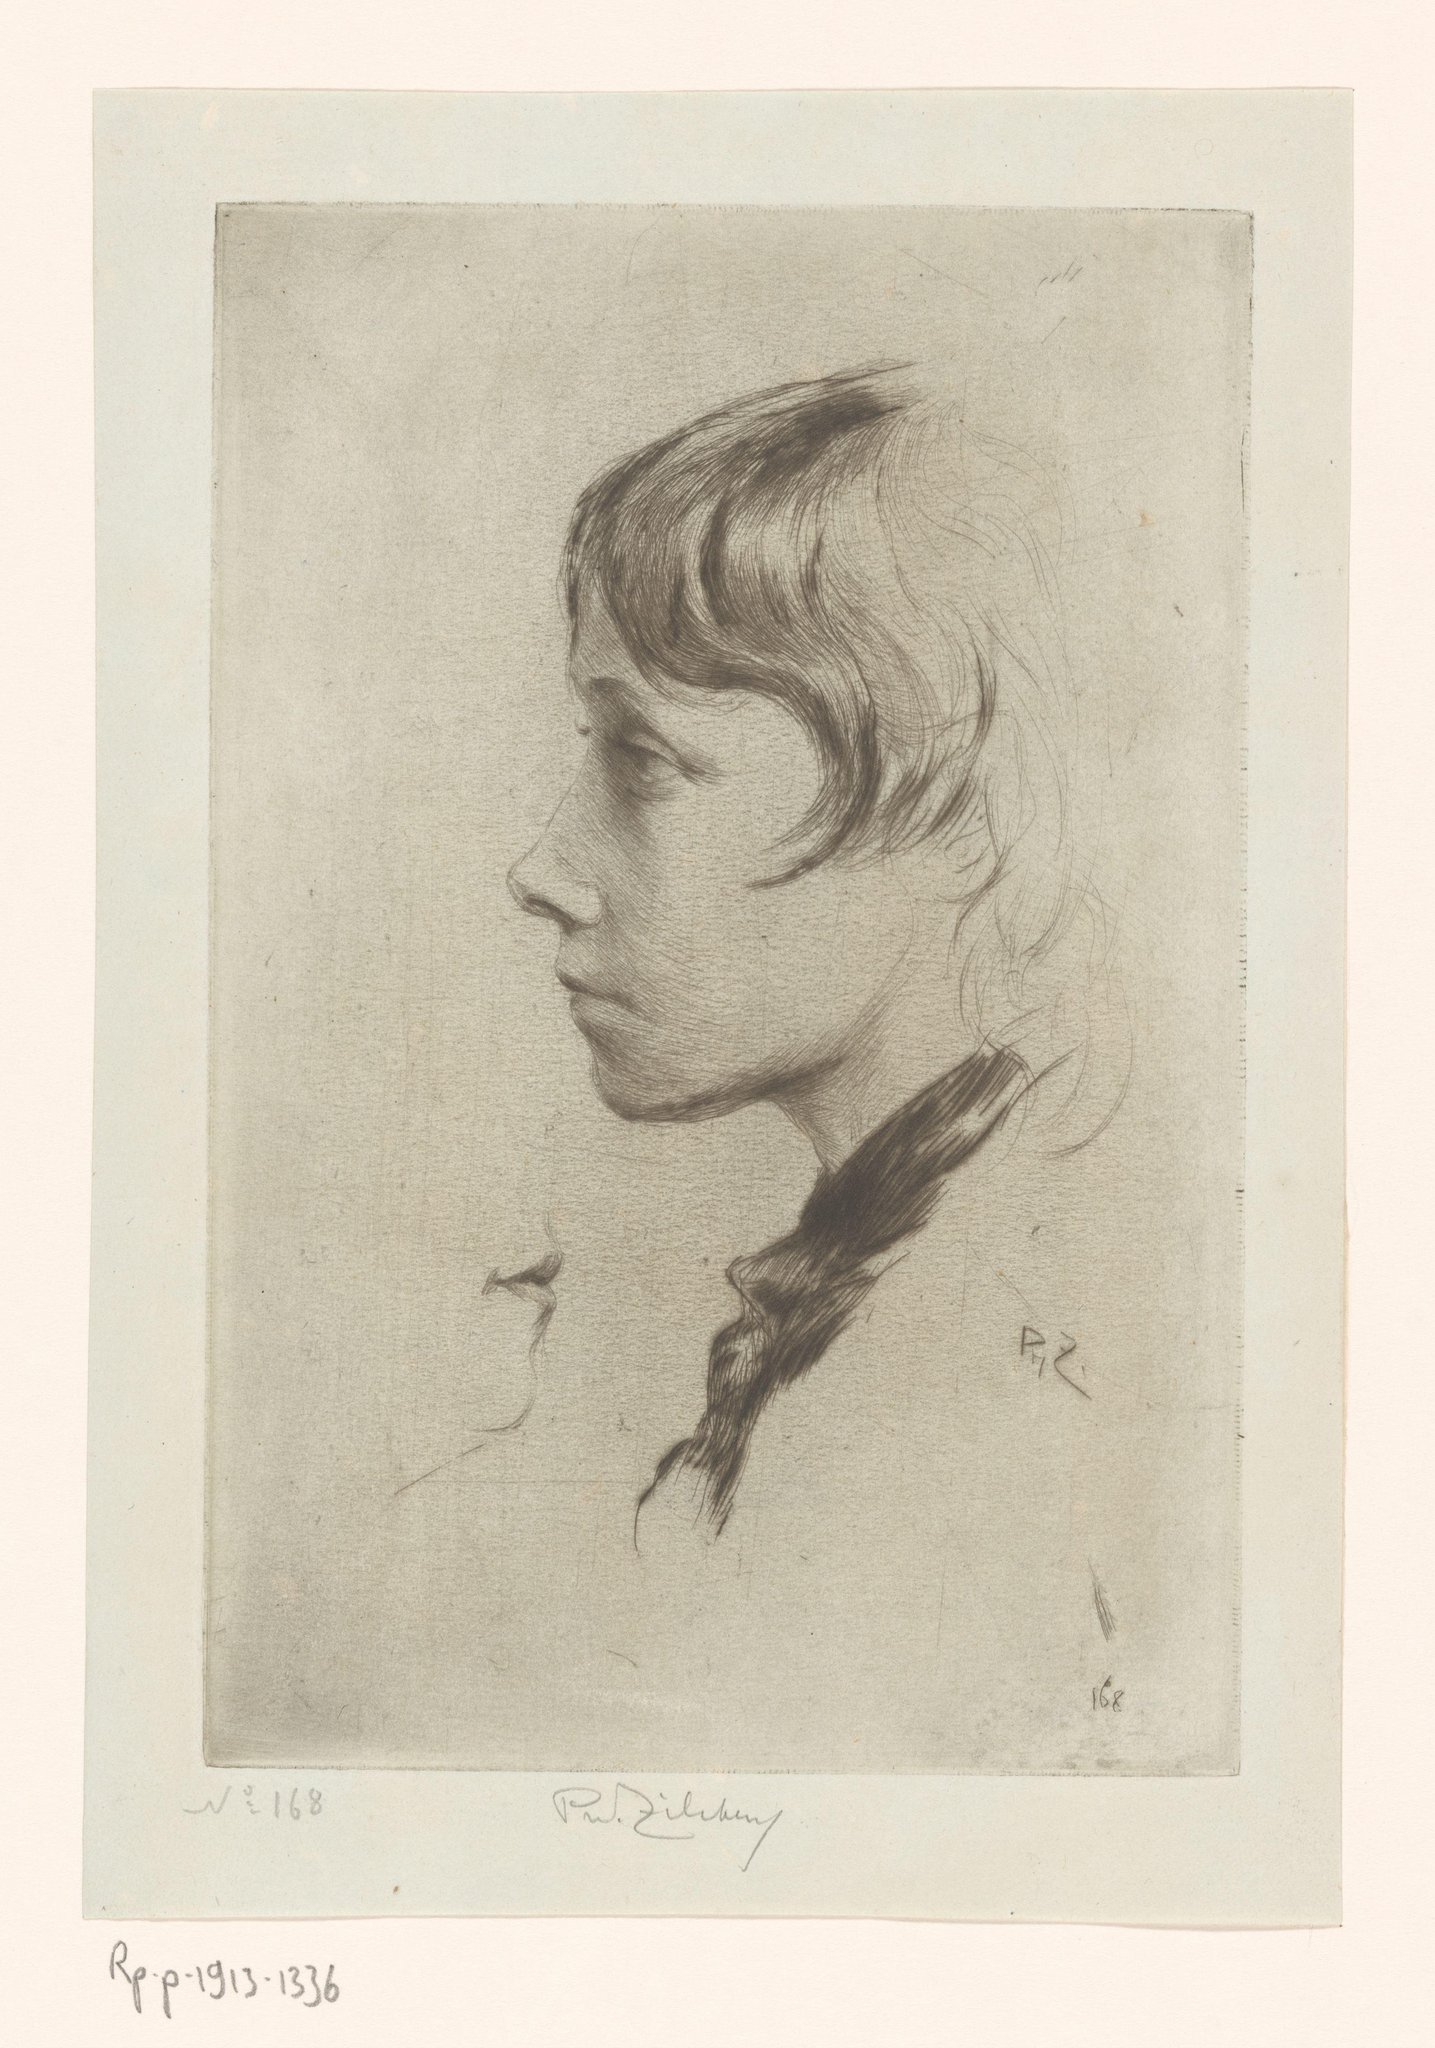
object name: print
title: Hoofd van een meisje, en profil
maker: philip zilcken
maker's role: draughtsman, painter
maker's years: 1857-1930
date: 1867-1890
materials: paper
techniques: drypoint, intaglio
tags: adolescent, young woman, maiden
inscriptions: collector's mark: Lugt 2233